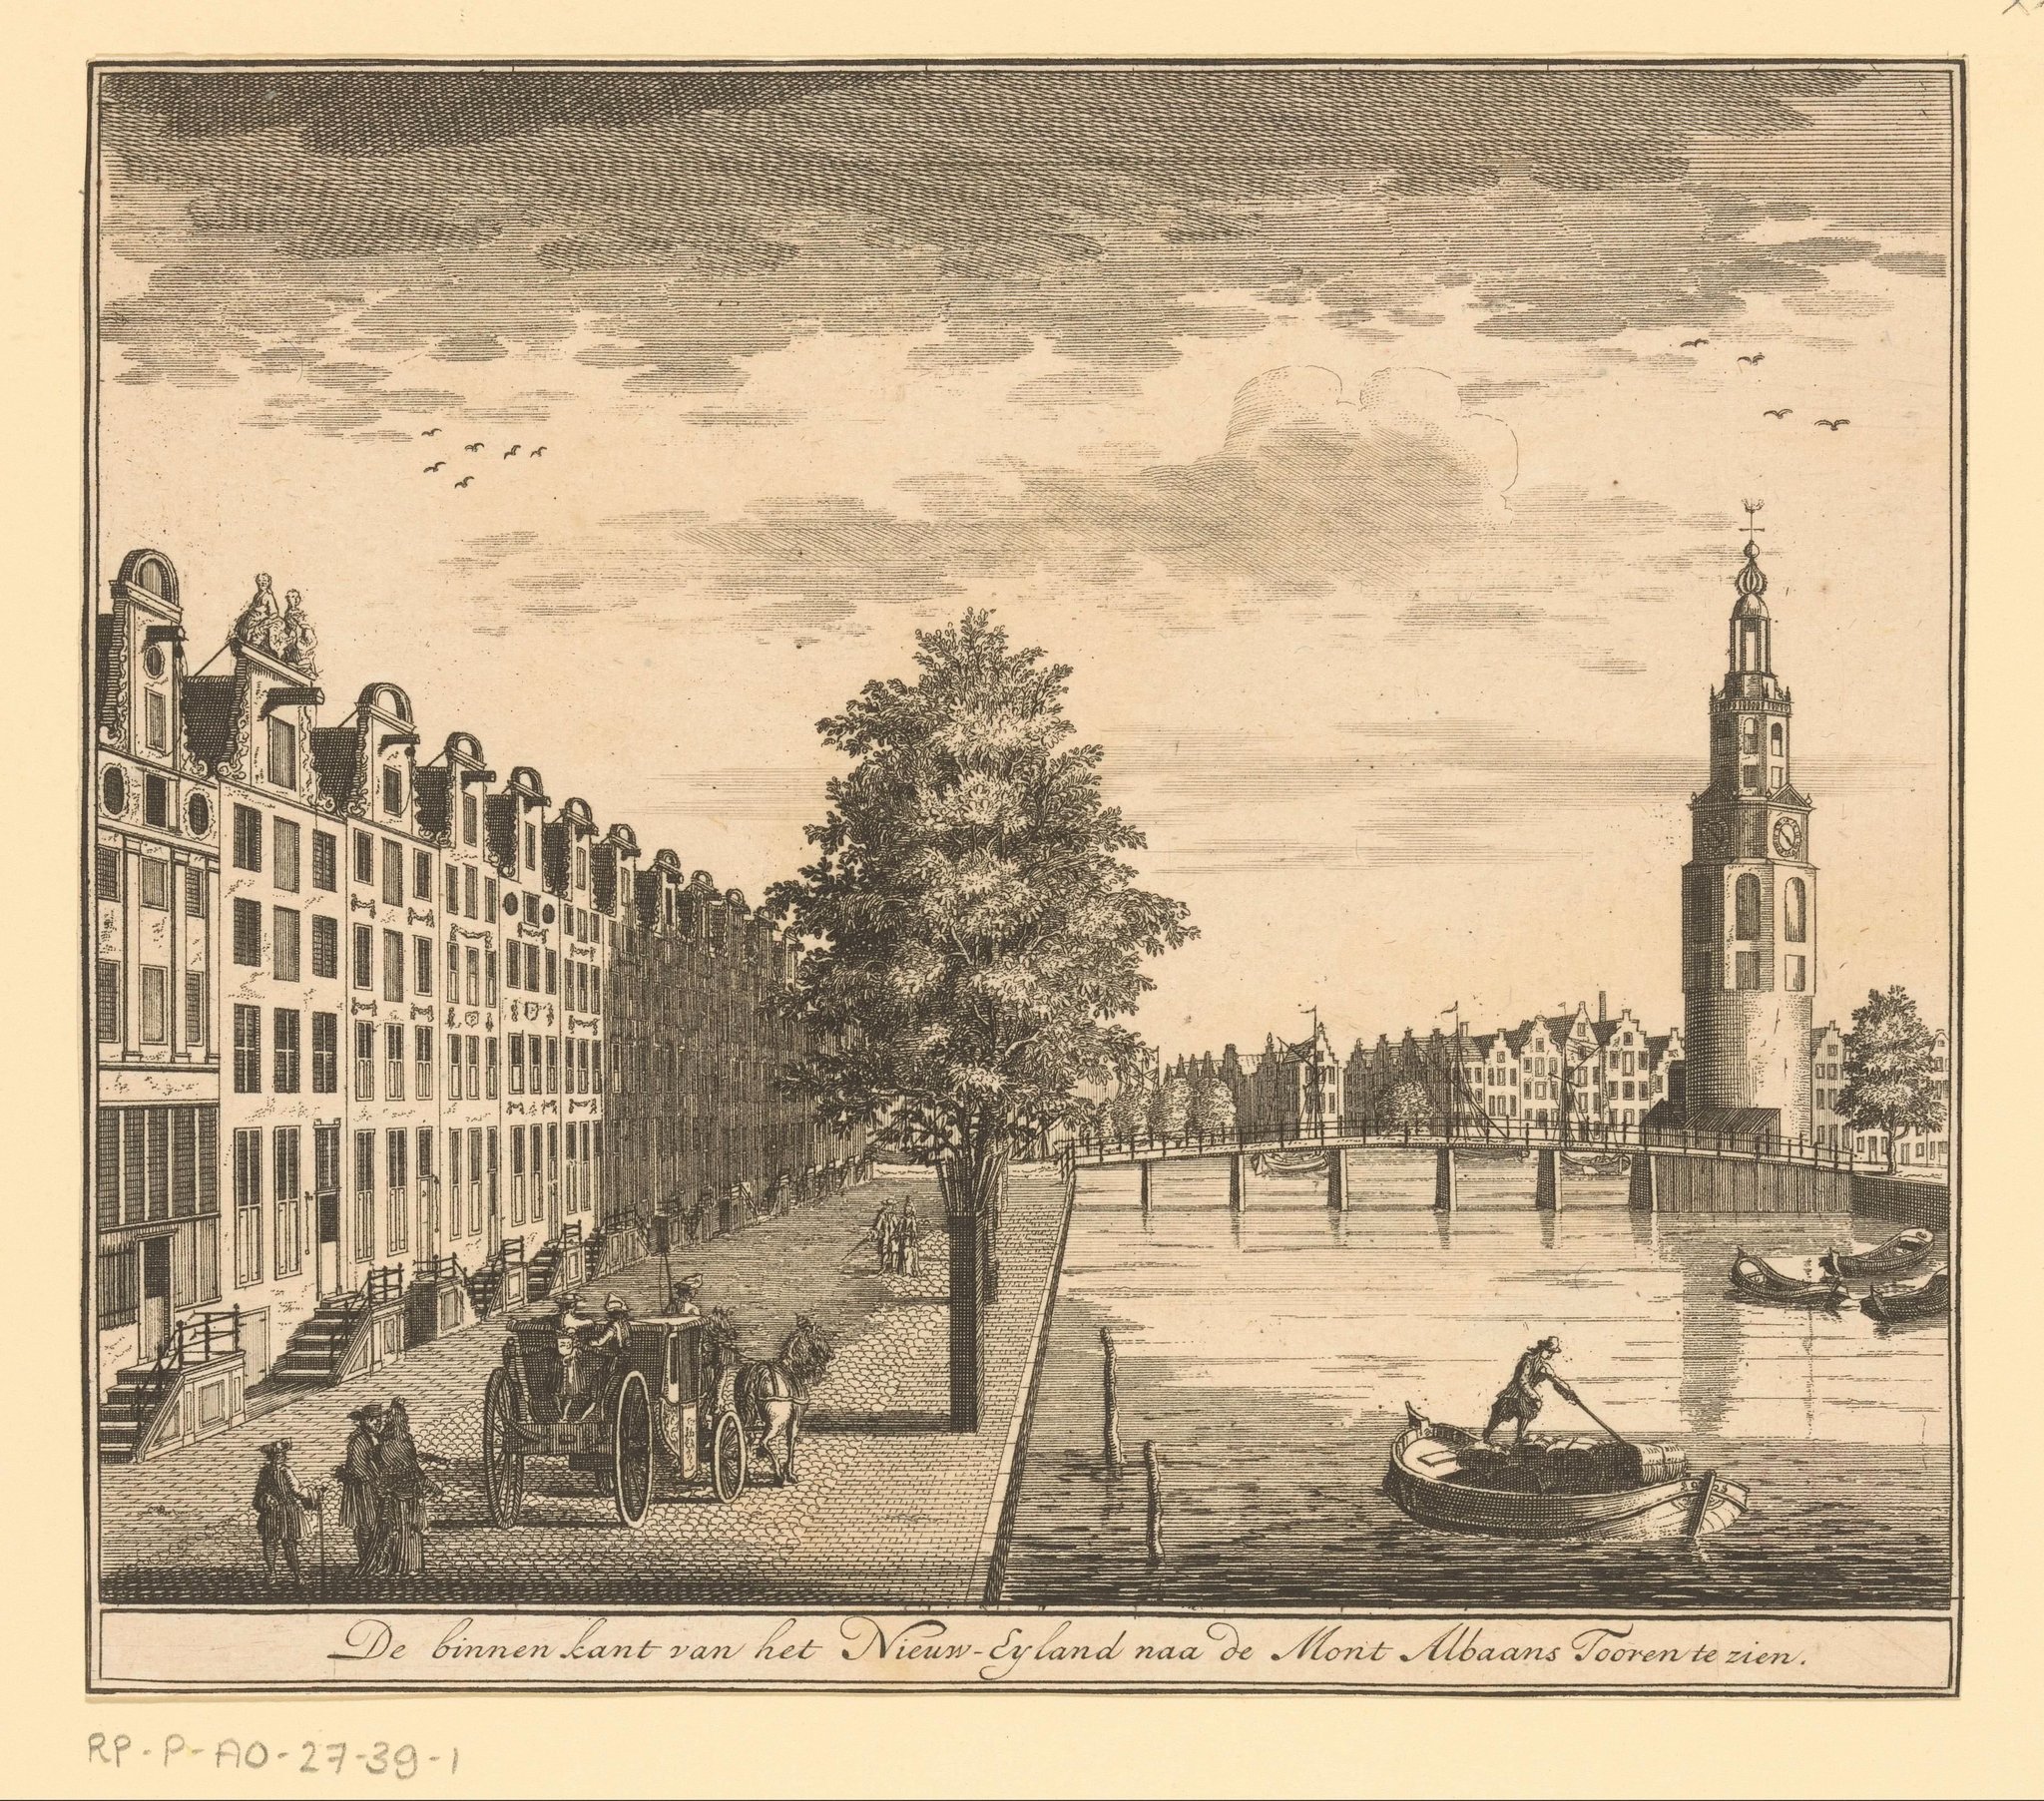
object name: print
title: Gezicht op de Binnenkant en de Montelbaanstoren te Amsterdam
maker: Anonymous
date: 1700-1749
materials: paper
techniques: engraving, etching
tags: bridge in city across river, canal, etc. (+ city(-scape) with figures, staffage), tower, clock tower ~ monumental adornment, towers ~ fortified city, canals, waters (in city) (+ city(-scape) with figures, staffage), street (+ city(-scape) with figures, staffage)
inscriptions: collector's mark: Lugt 195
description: Tweede (of latere) staat van soortgelijke prenten (met toevoeging van Franse titel) ook gebruikt in: Le guide, ou nouvelle description d'Amsterdam; enseignant aux voyageurs, et aux negocians (…) Avec une description de sa belle Maison de Ville (…). Amsterdam: Covens & Mortier & Covens Jr., 1772.